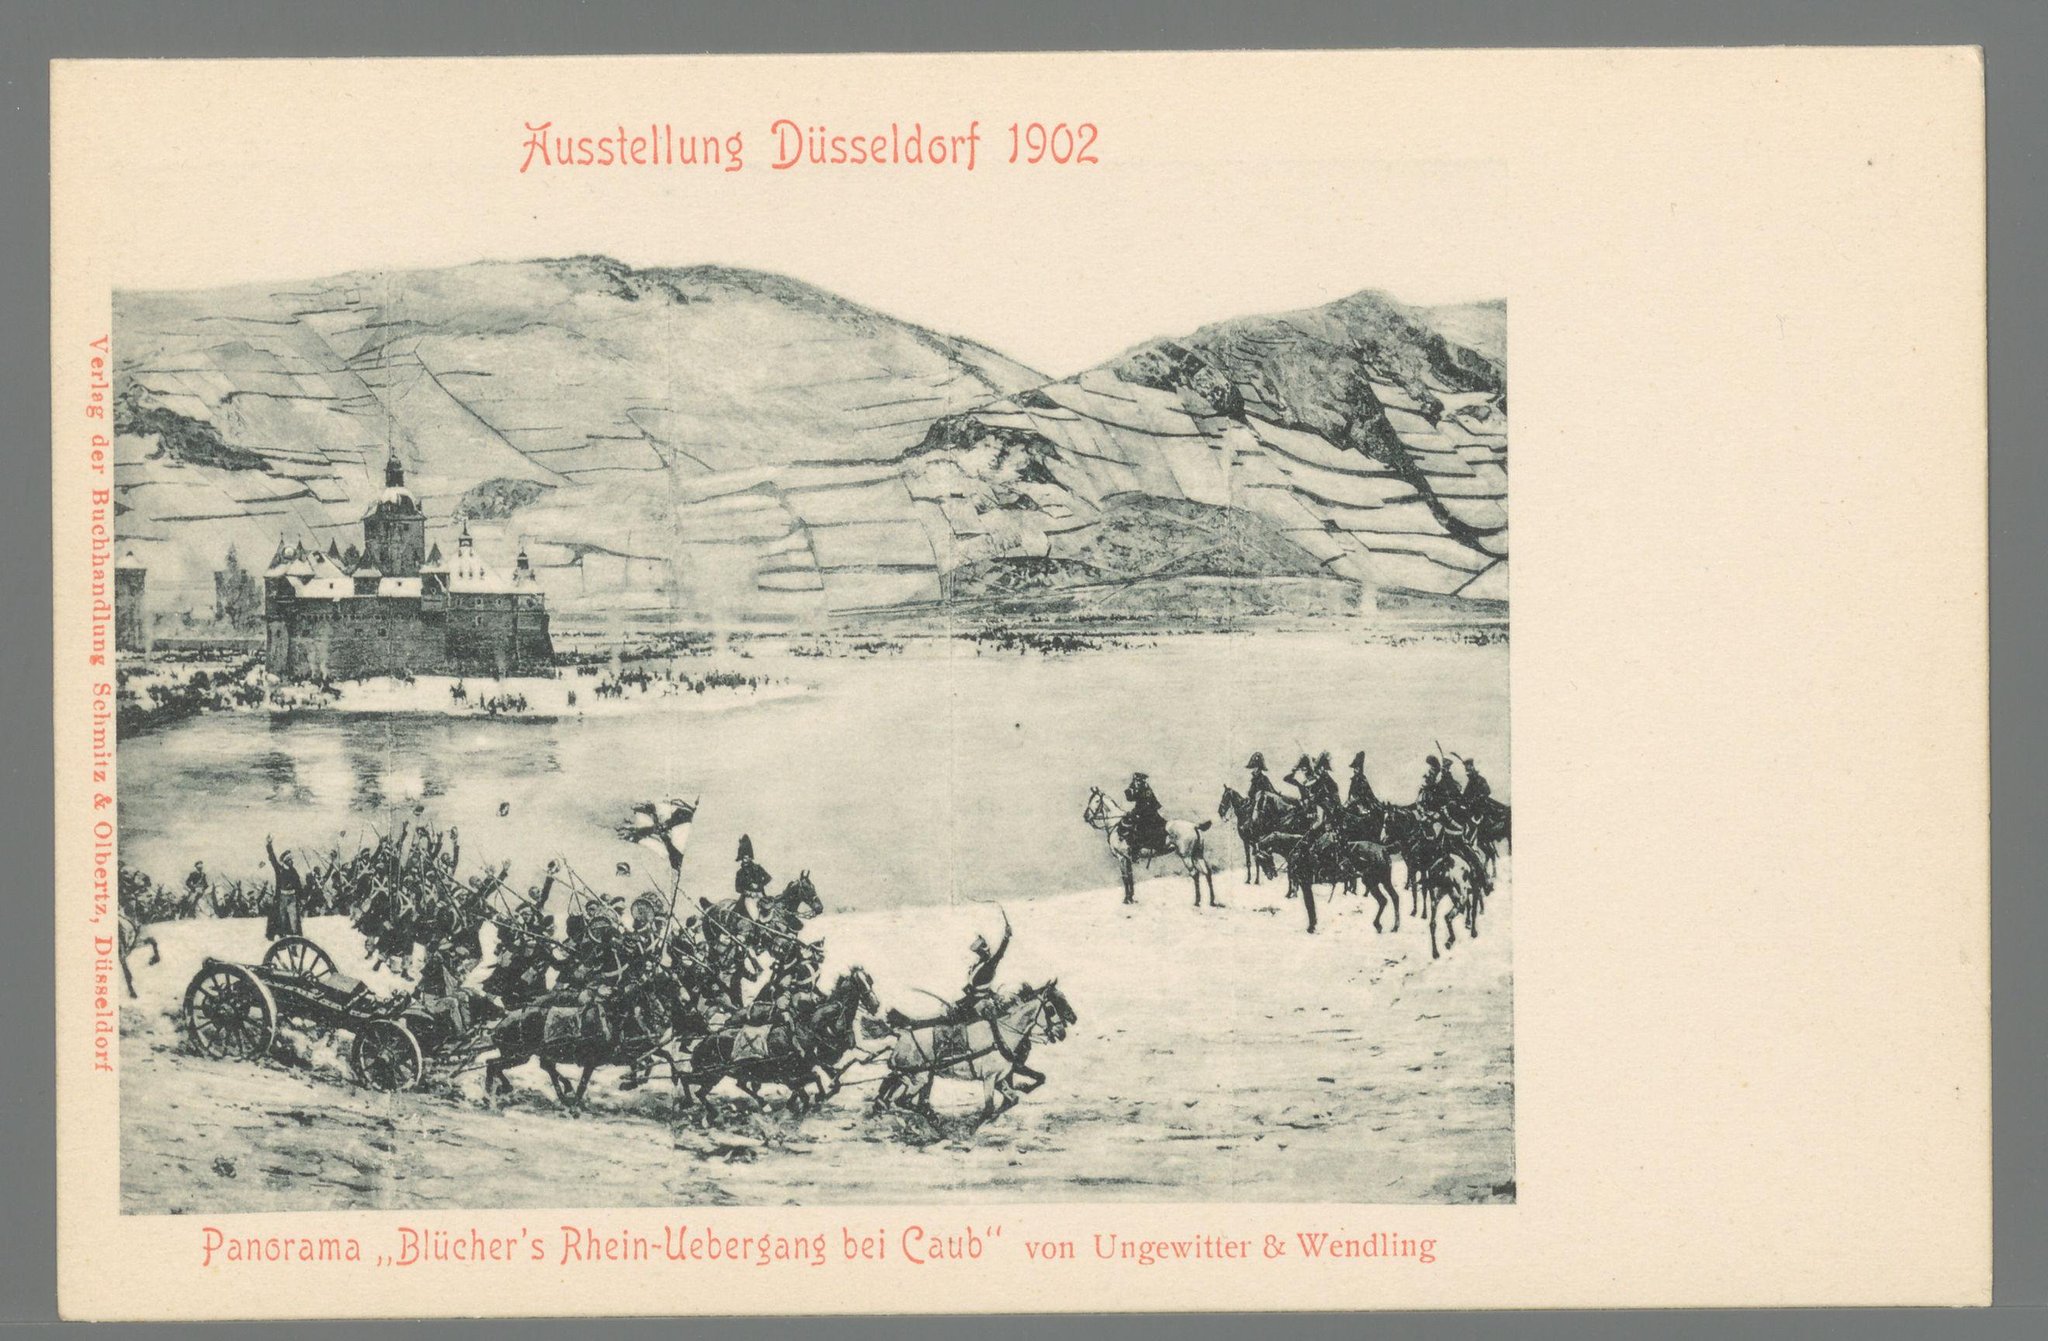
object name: photomechanical print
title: Ausstellung Düsseldorf 1902. Panorama "Blücher's Rhein-Uebergang bei Caub" von Ungewitter & Wending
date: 1902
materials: cardboard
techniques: photograph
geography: dresden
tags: army 'en route', castle, canals, waters (in city), temporary exhibition, 'salon'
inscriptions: date